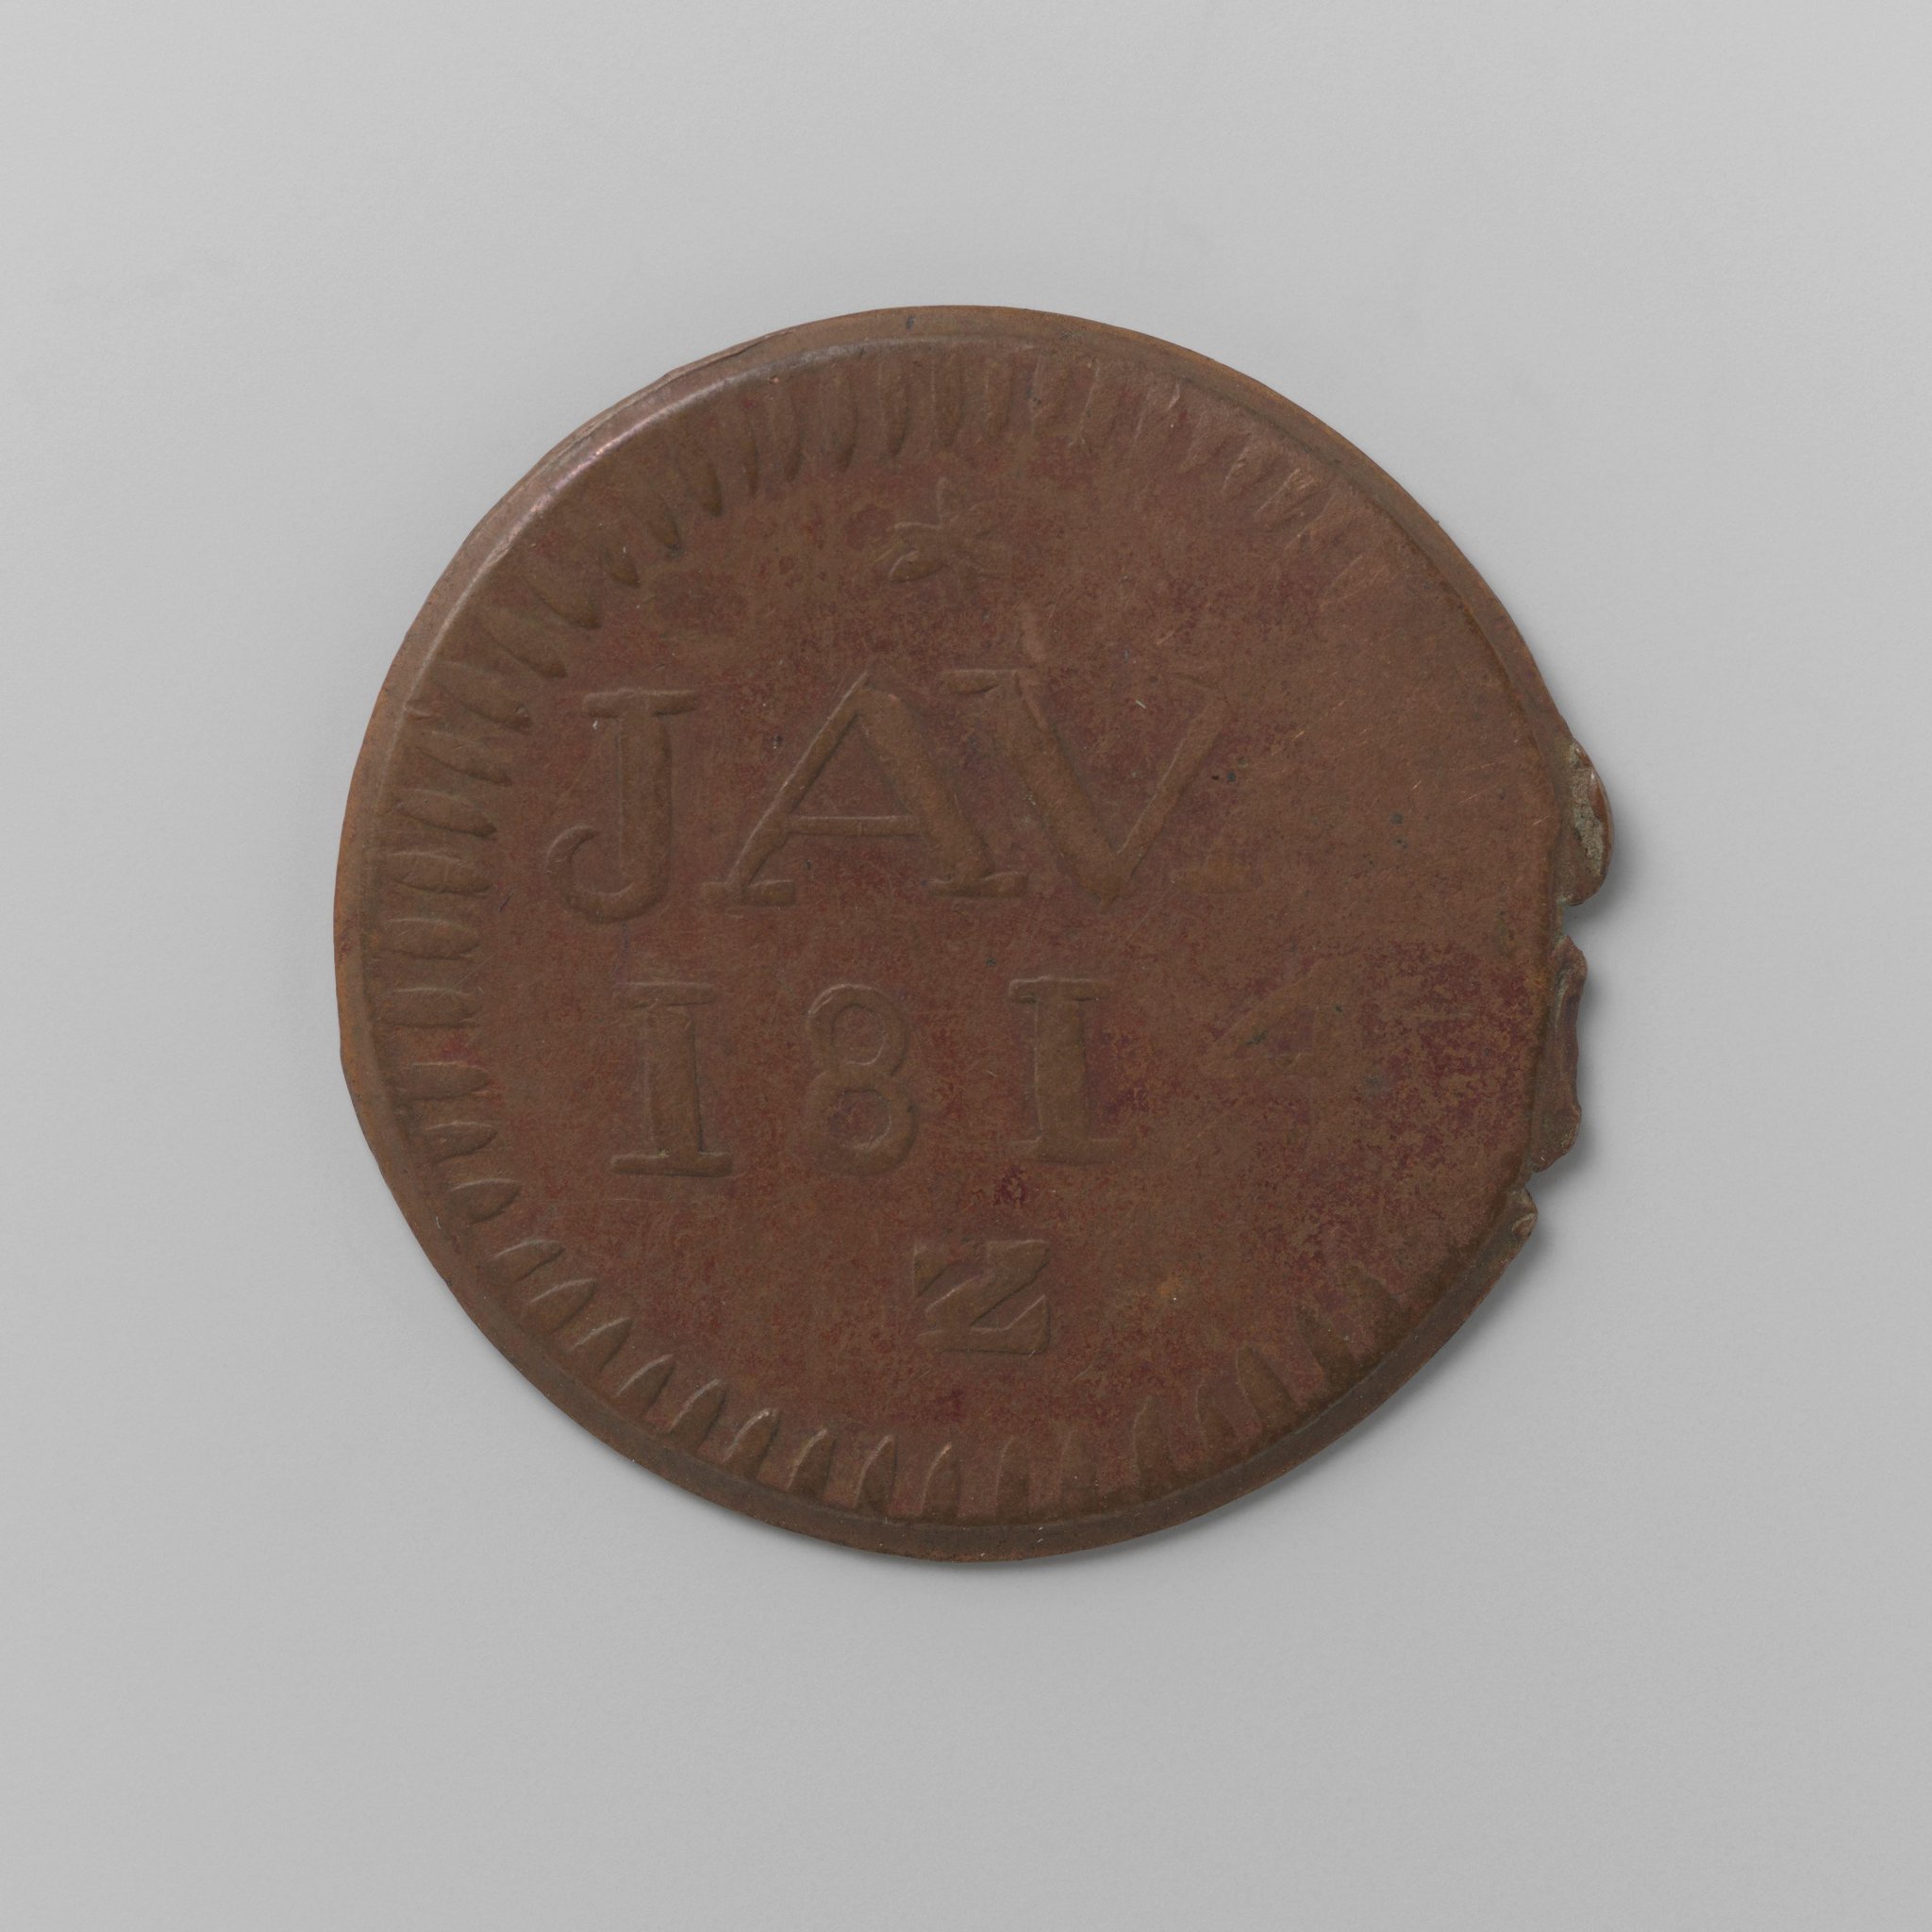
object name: coin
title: Nederlands Indië tijdens Brits bestuur, ½ stuiver Java, 1814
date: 1814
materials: copper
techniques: striking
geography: surabaya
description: Koperen munt. Voorzijde: tussen waarde-aanduiding ½ St monogram van de Engelse Oostindische Compagnie. Daarboven letter B [=British]. Keerzijde: eenregelig opschrift, waaronder jaartal. Boven opschrift muntteken en onder jaartal muntmeesterteken Z [=muntmeester Zwekkert].